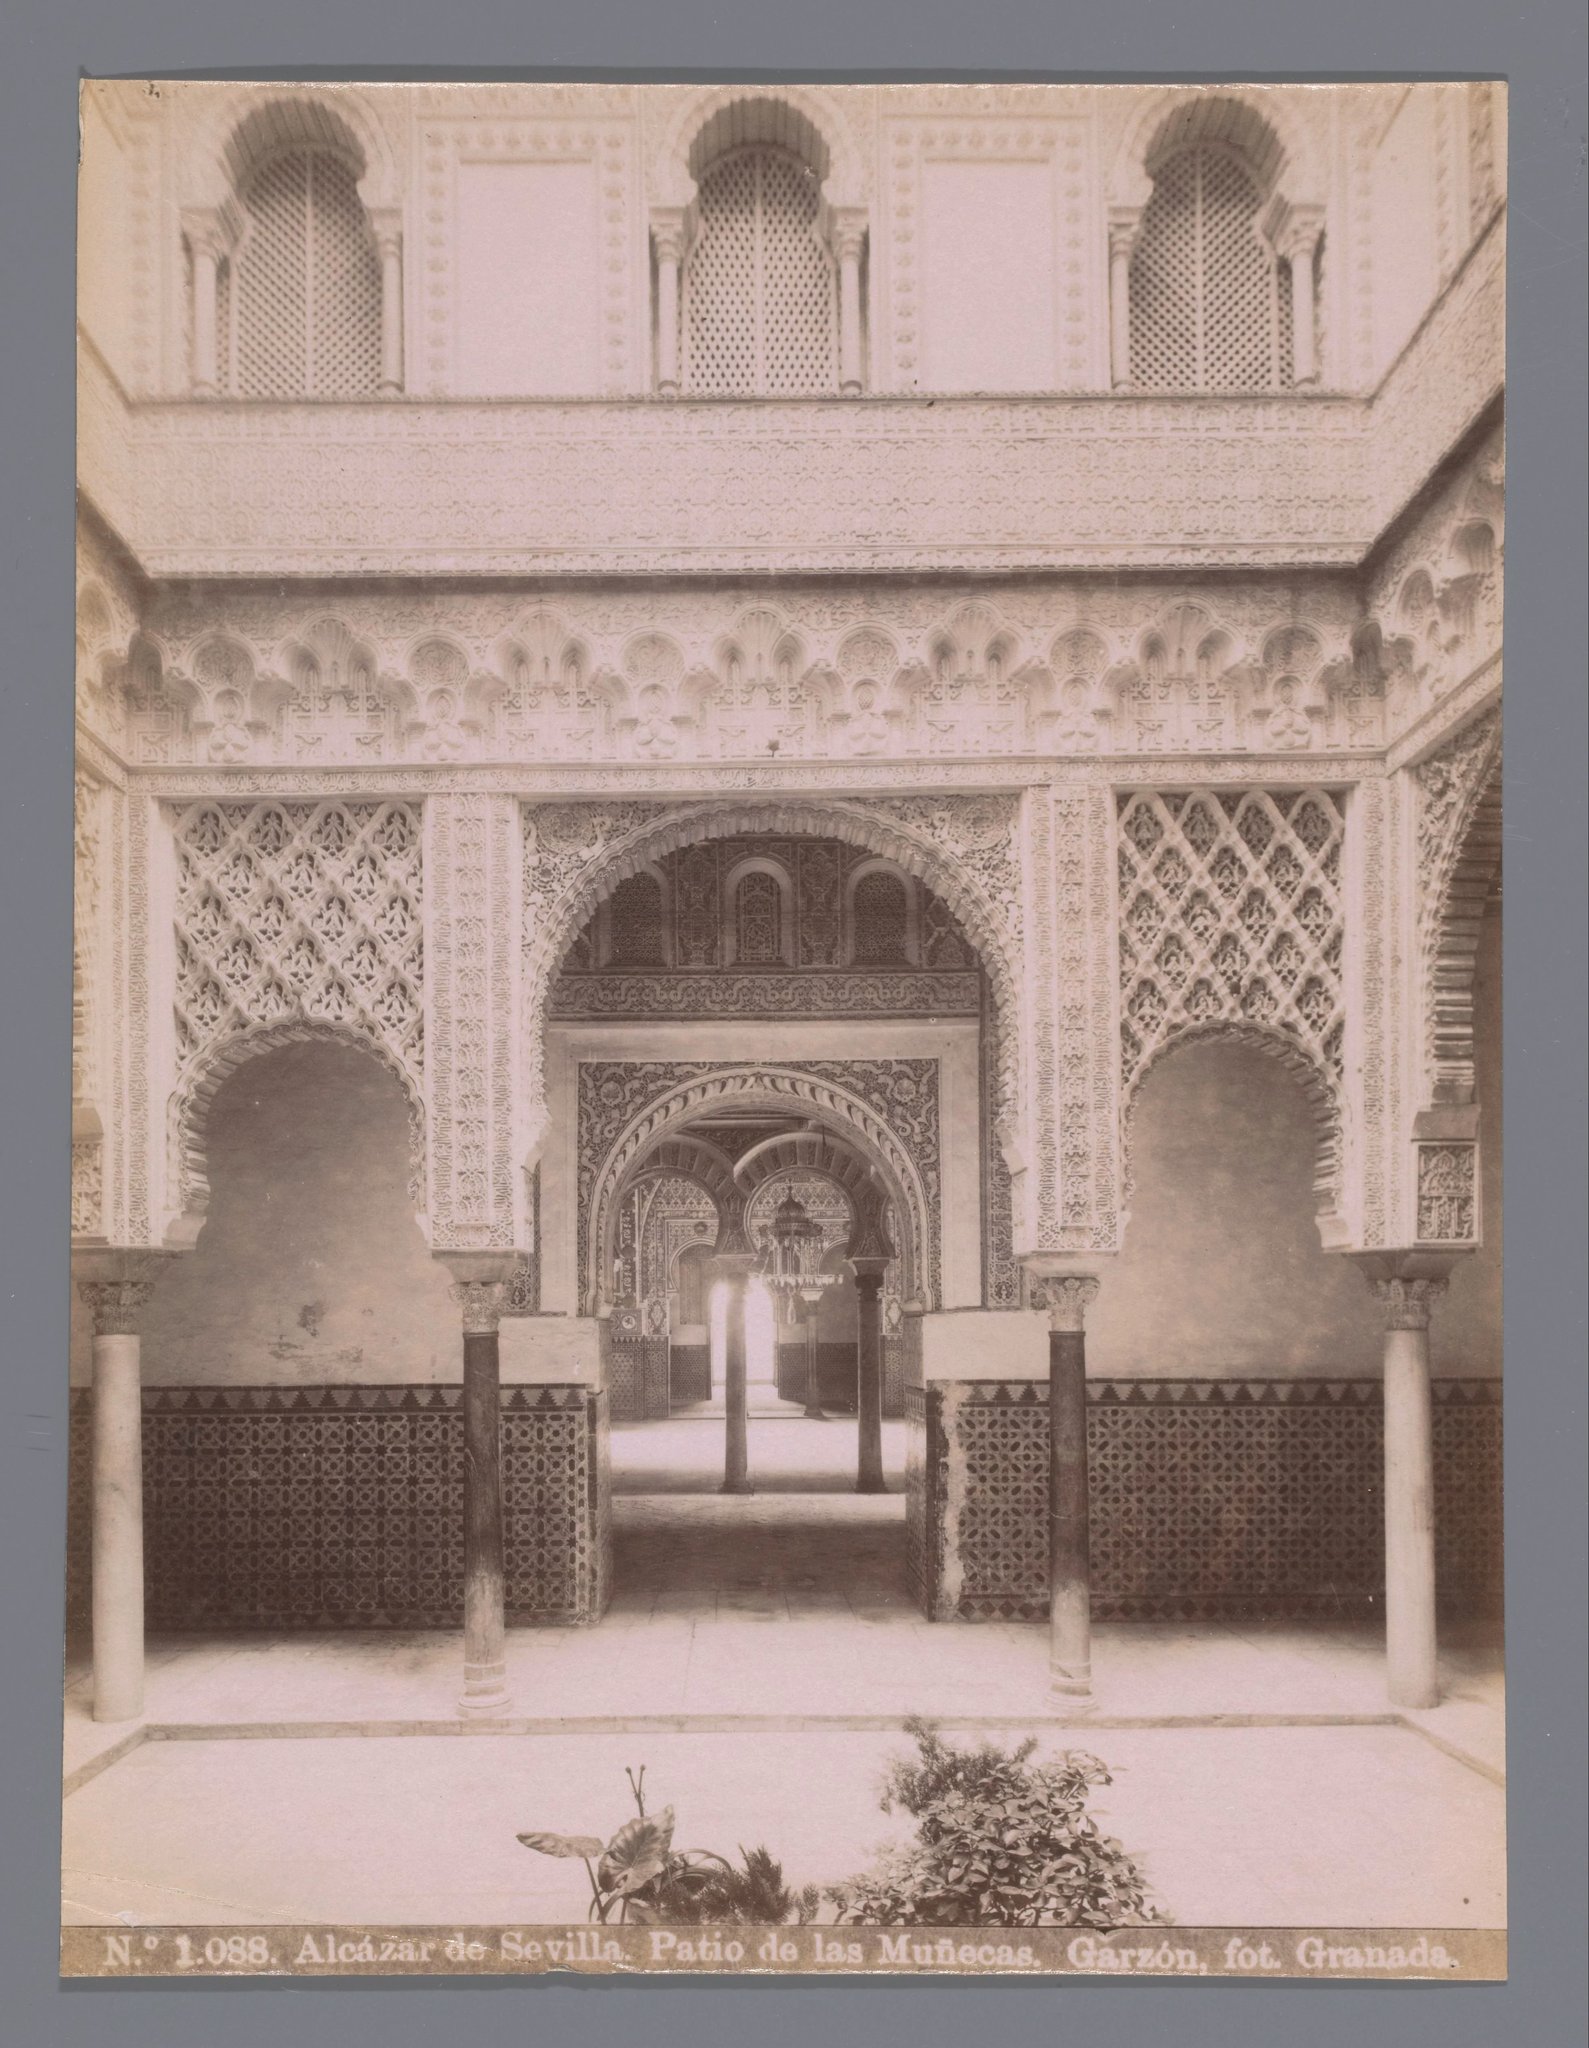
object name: photograph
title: Alcazar de Sevilla, Patio de las Muñecas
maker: rafael garzón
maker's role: publisher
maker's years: 1863-1923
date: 1880-1900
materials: paper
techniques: albumen print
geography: sevilla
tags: inner court of palace or 'hôtel'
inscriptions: number: ‘No. 1.088.’